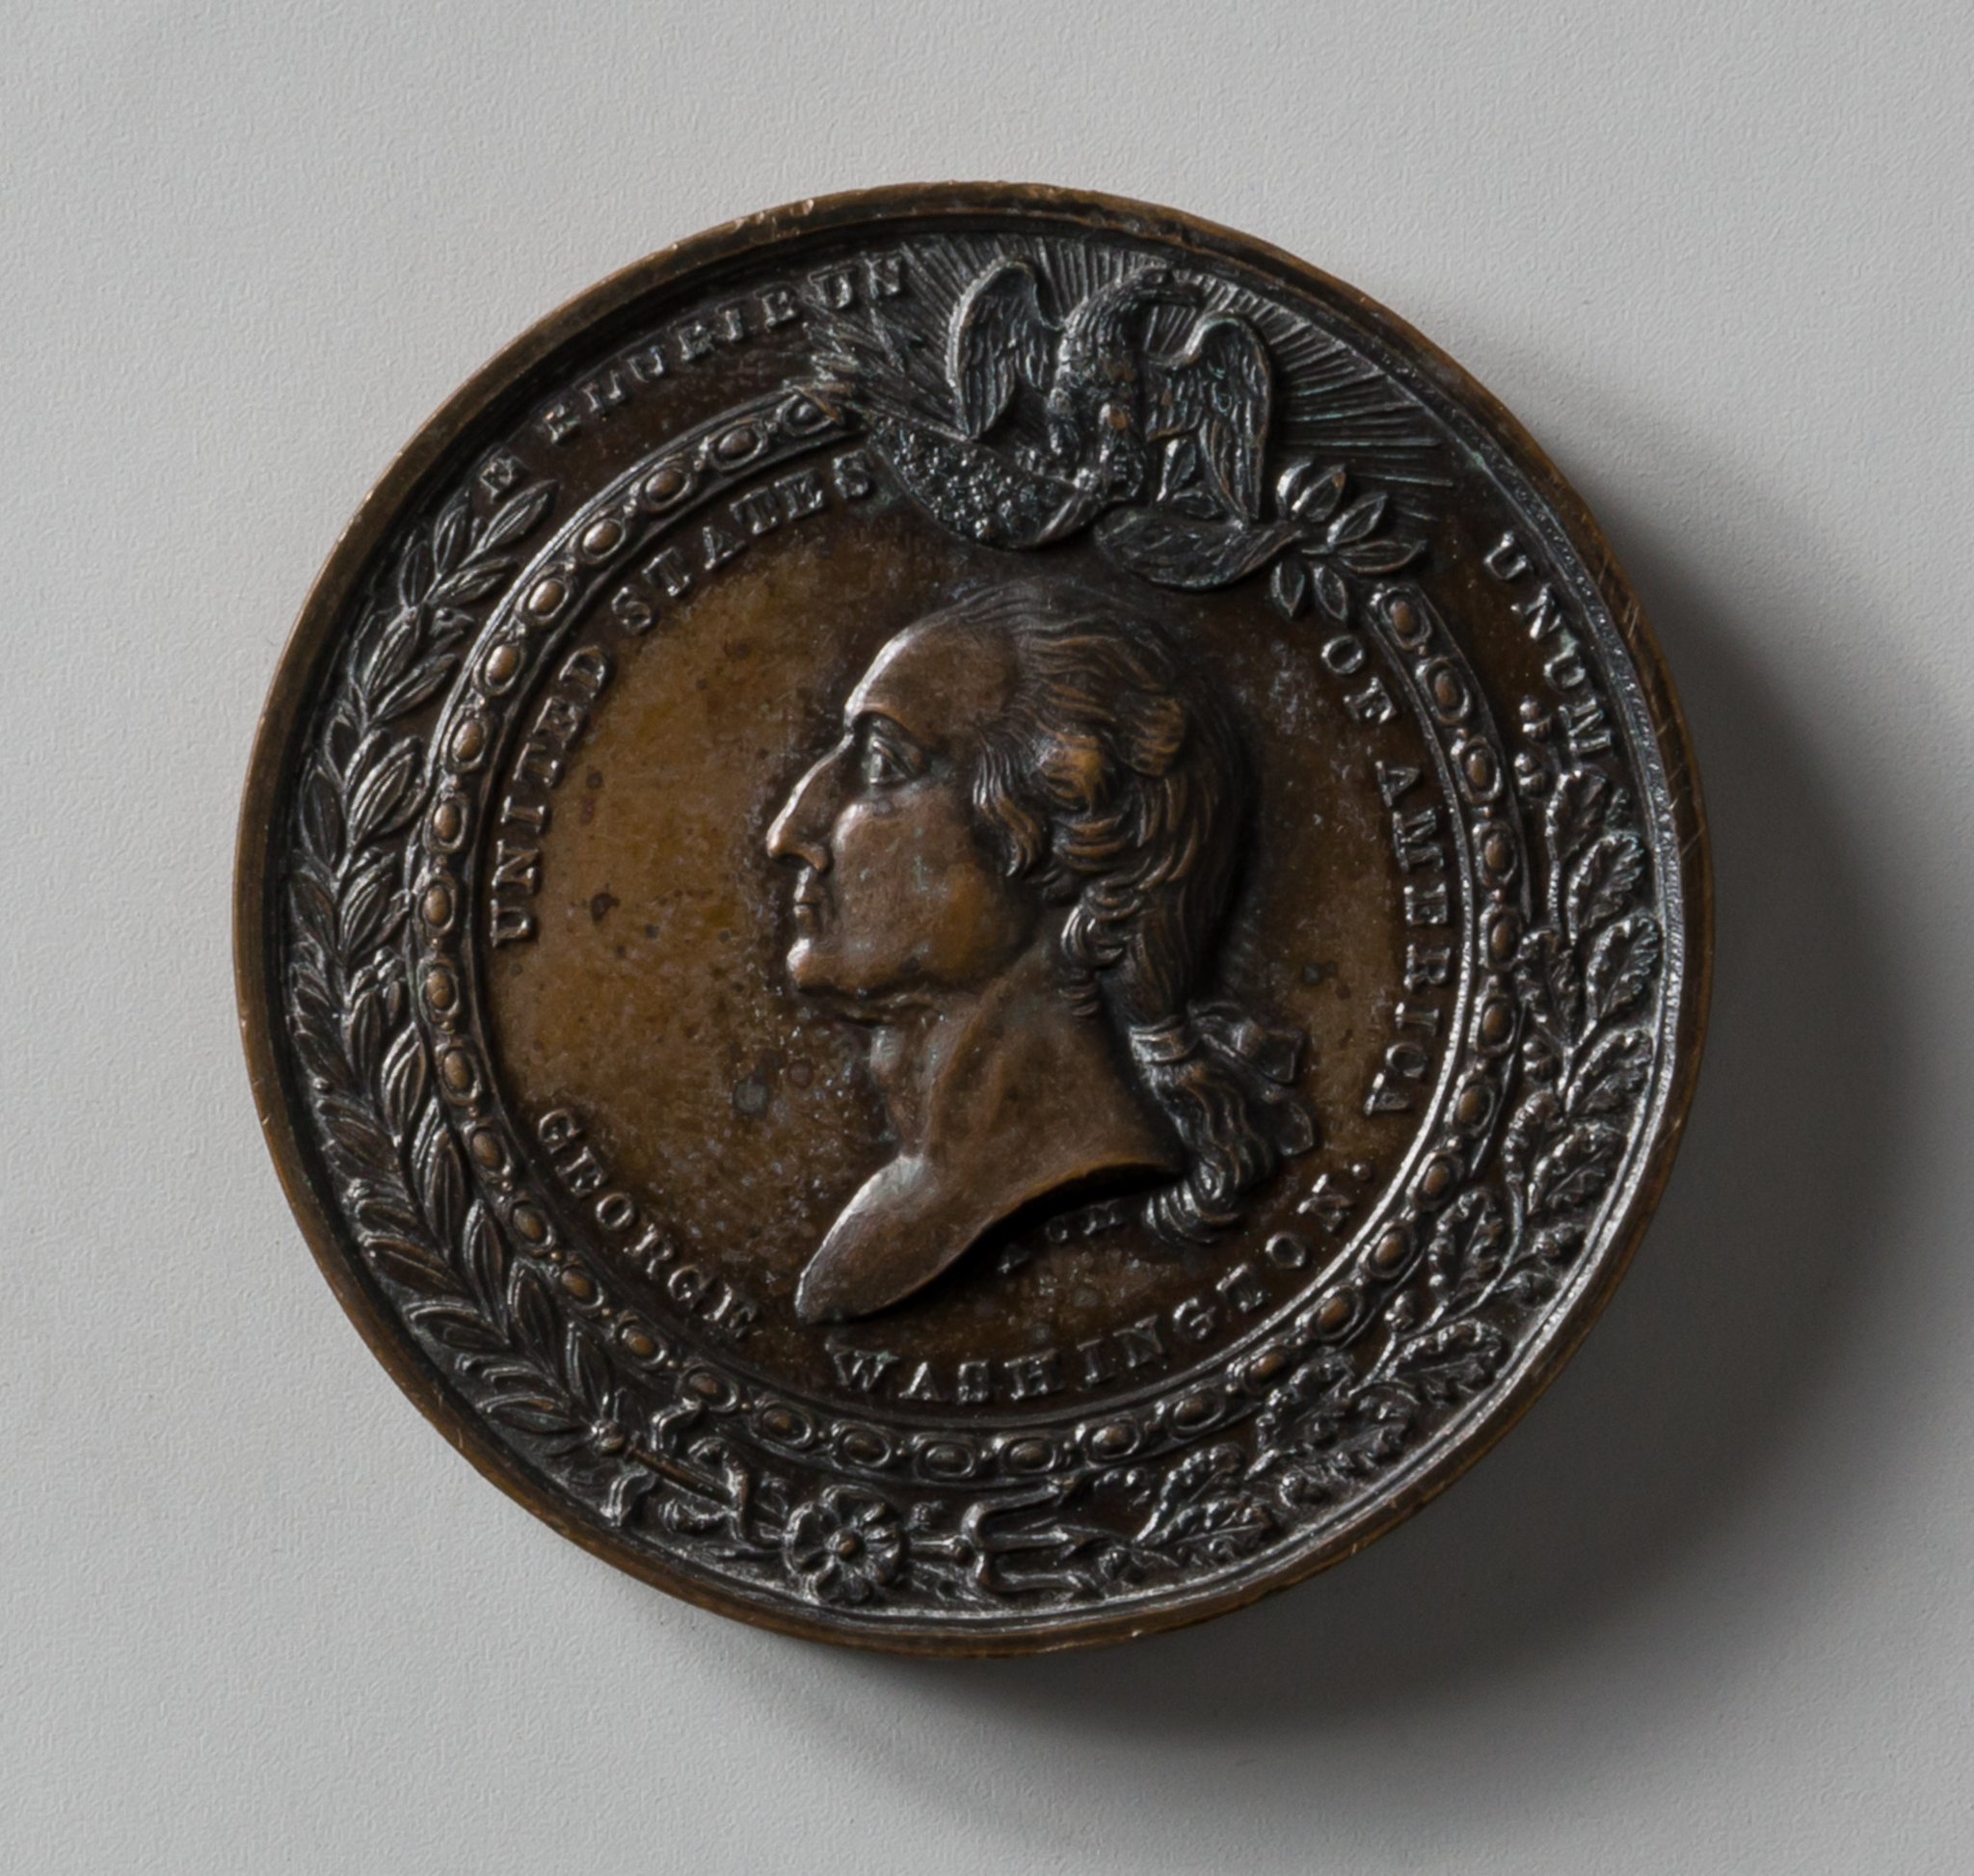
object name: medal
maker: anthony paquet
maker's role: maker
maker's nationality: american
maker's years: 1814-1882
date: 1853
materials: bronze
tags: eagles,george washington,portraits,profiles